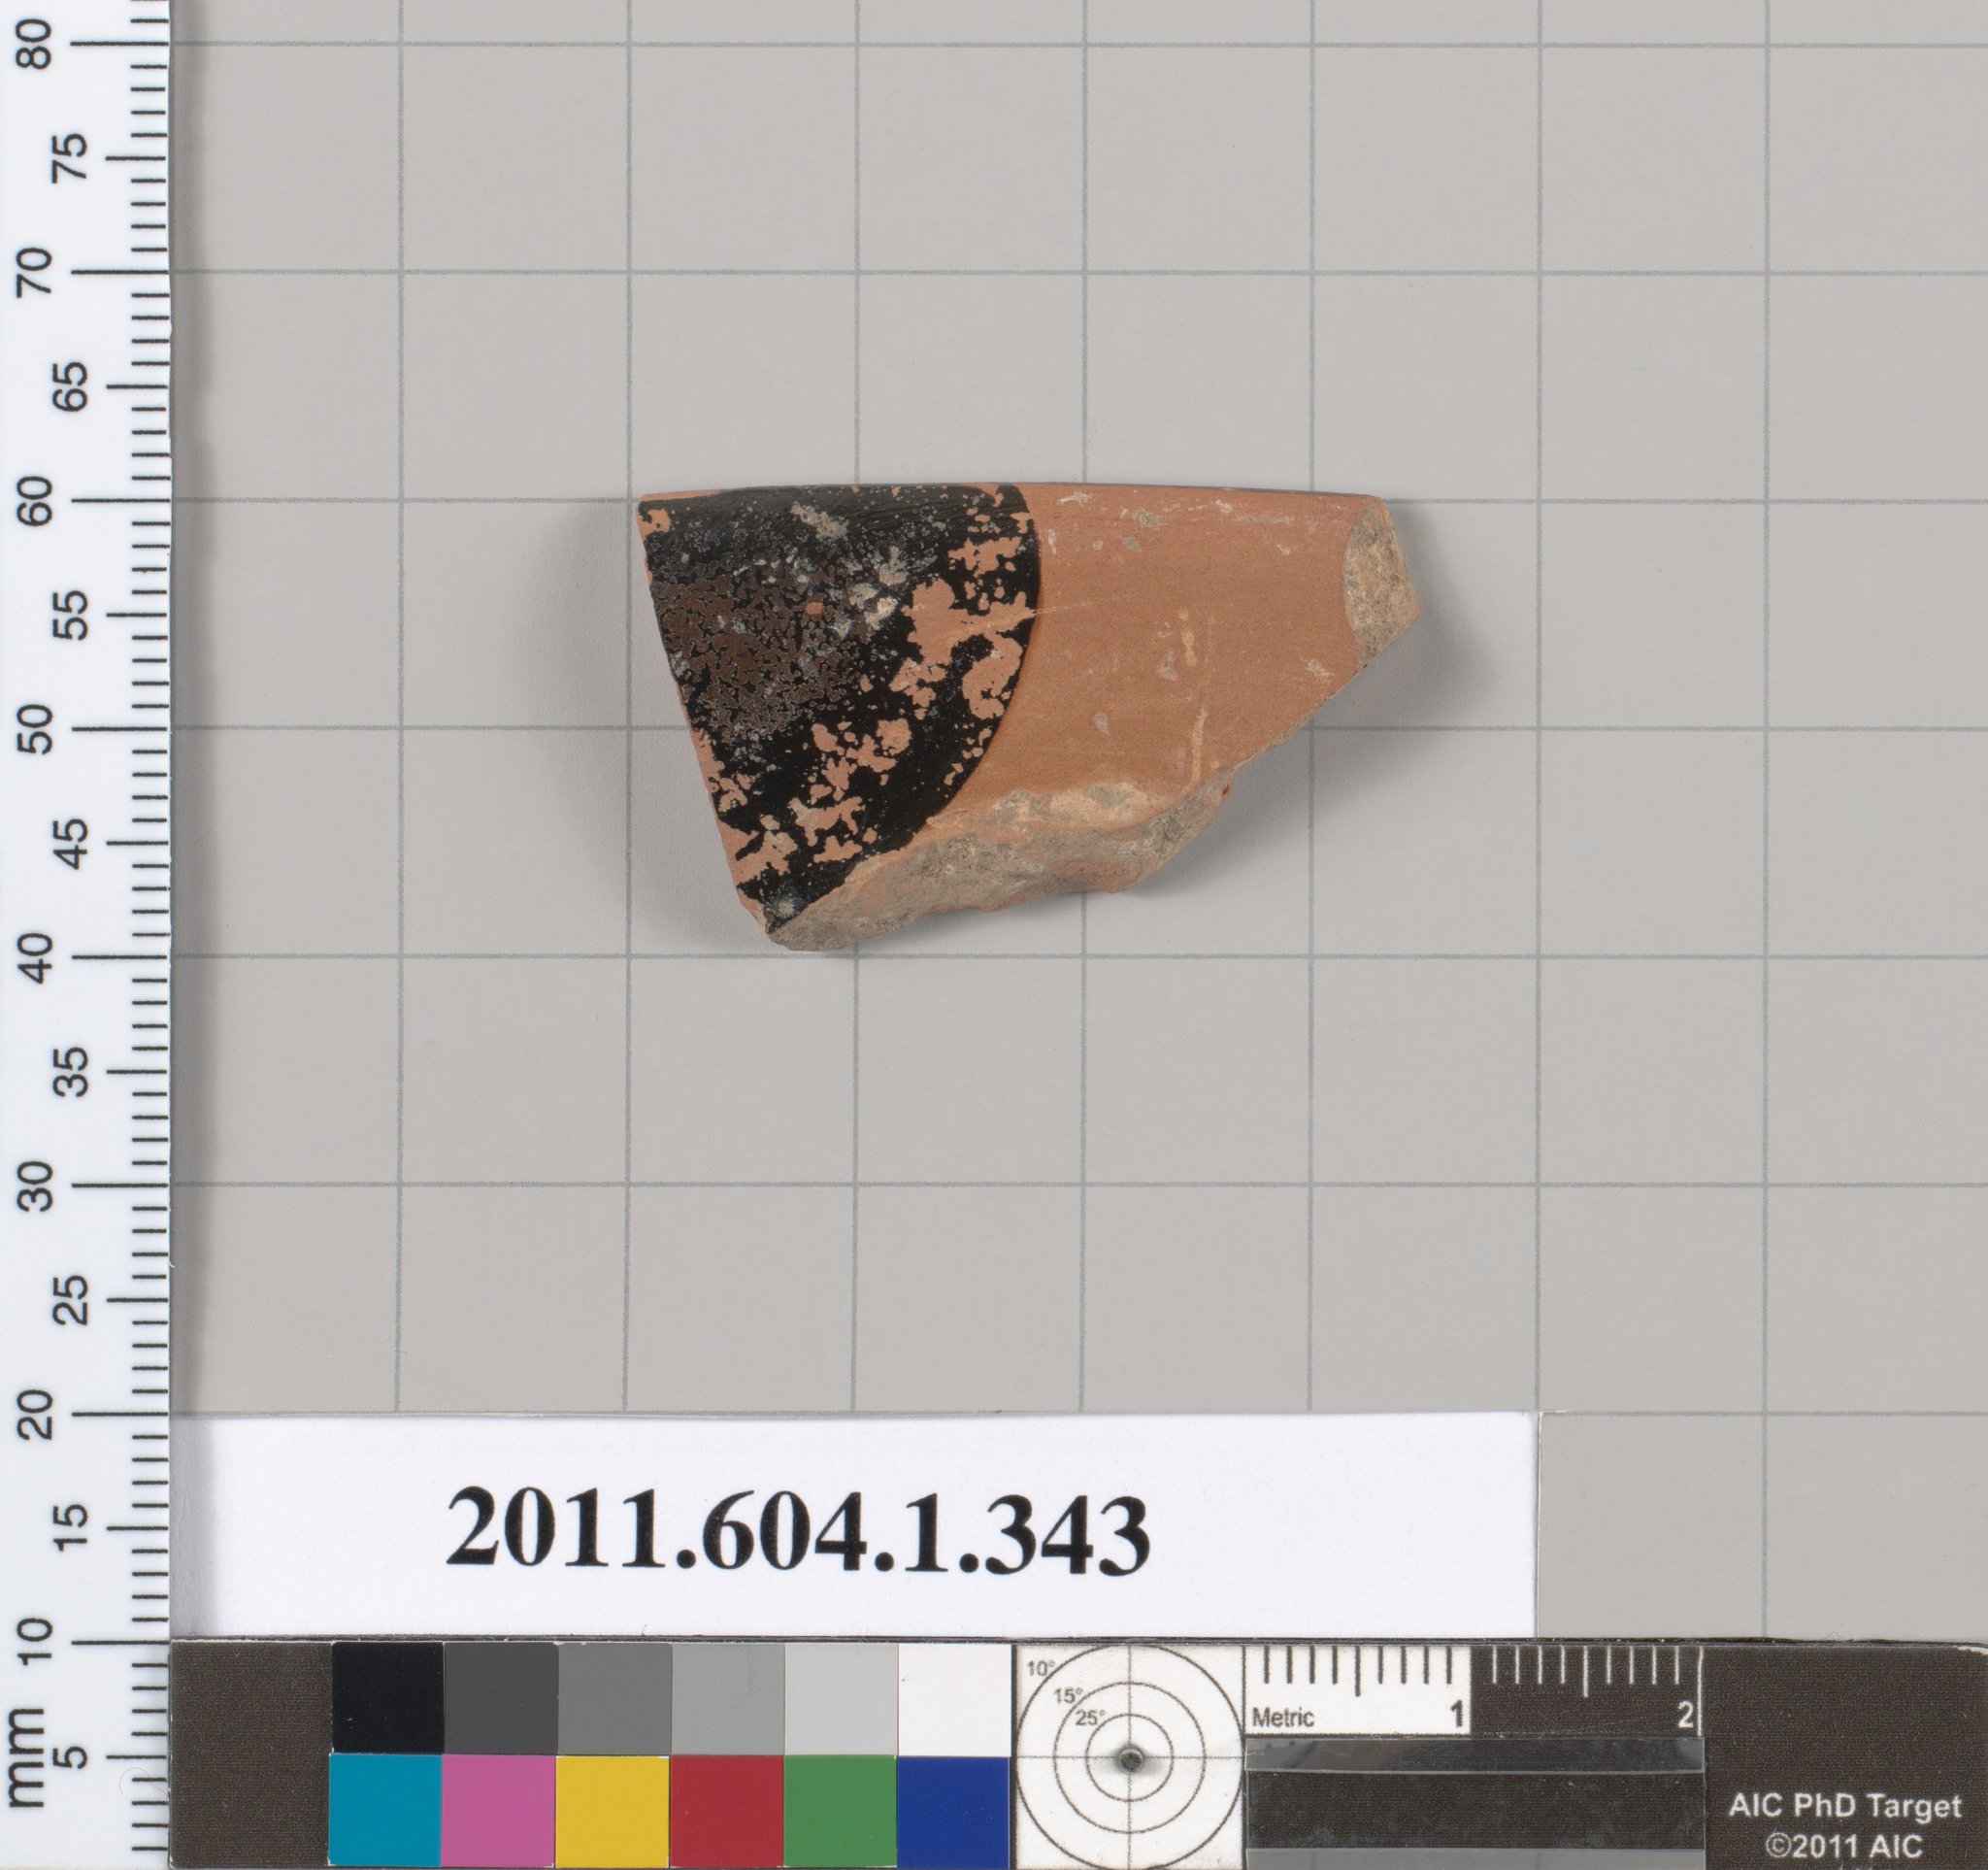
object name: kylix fragment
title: Terracotta rim fragment of a kylix (drinking cup)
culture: greek, attic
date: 475-451 BCE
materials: terracotta